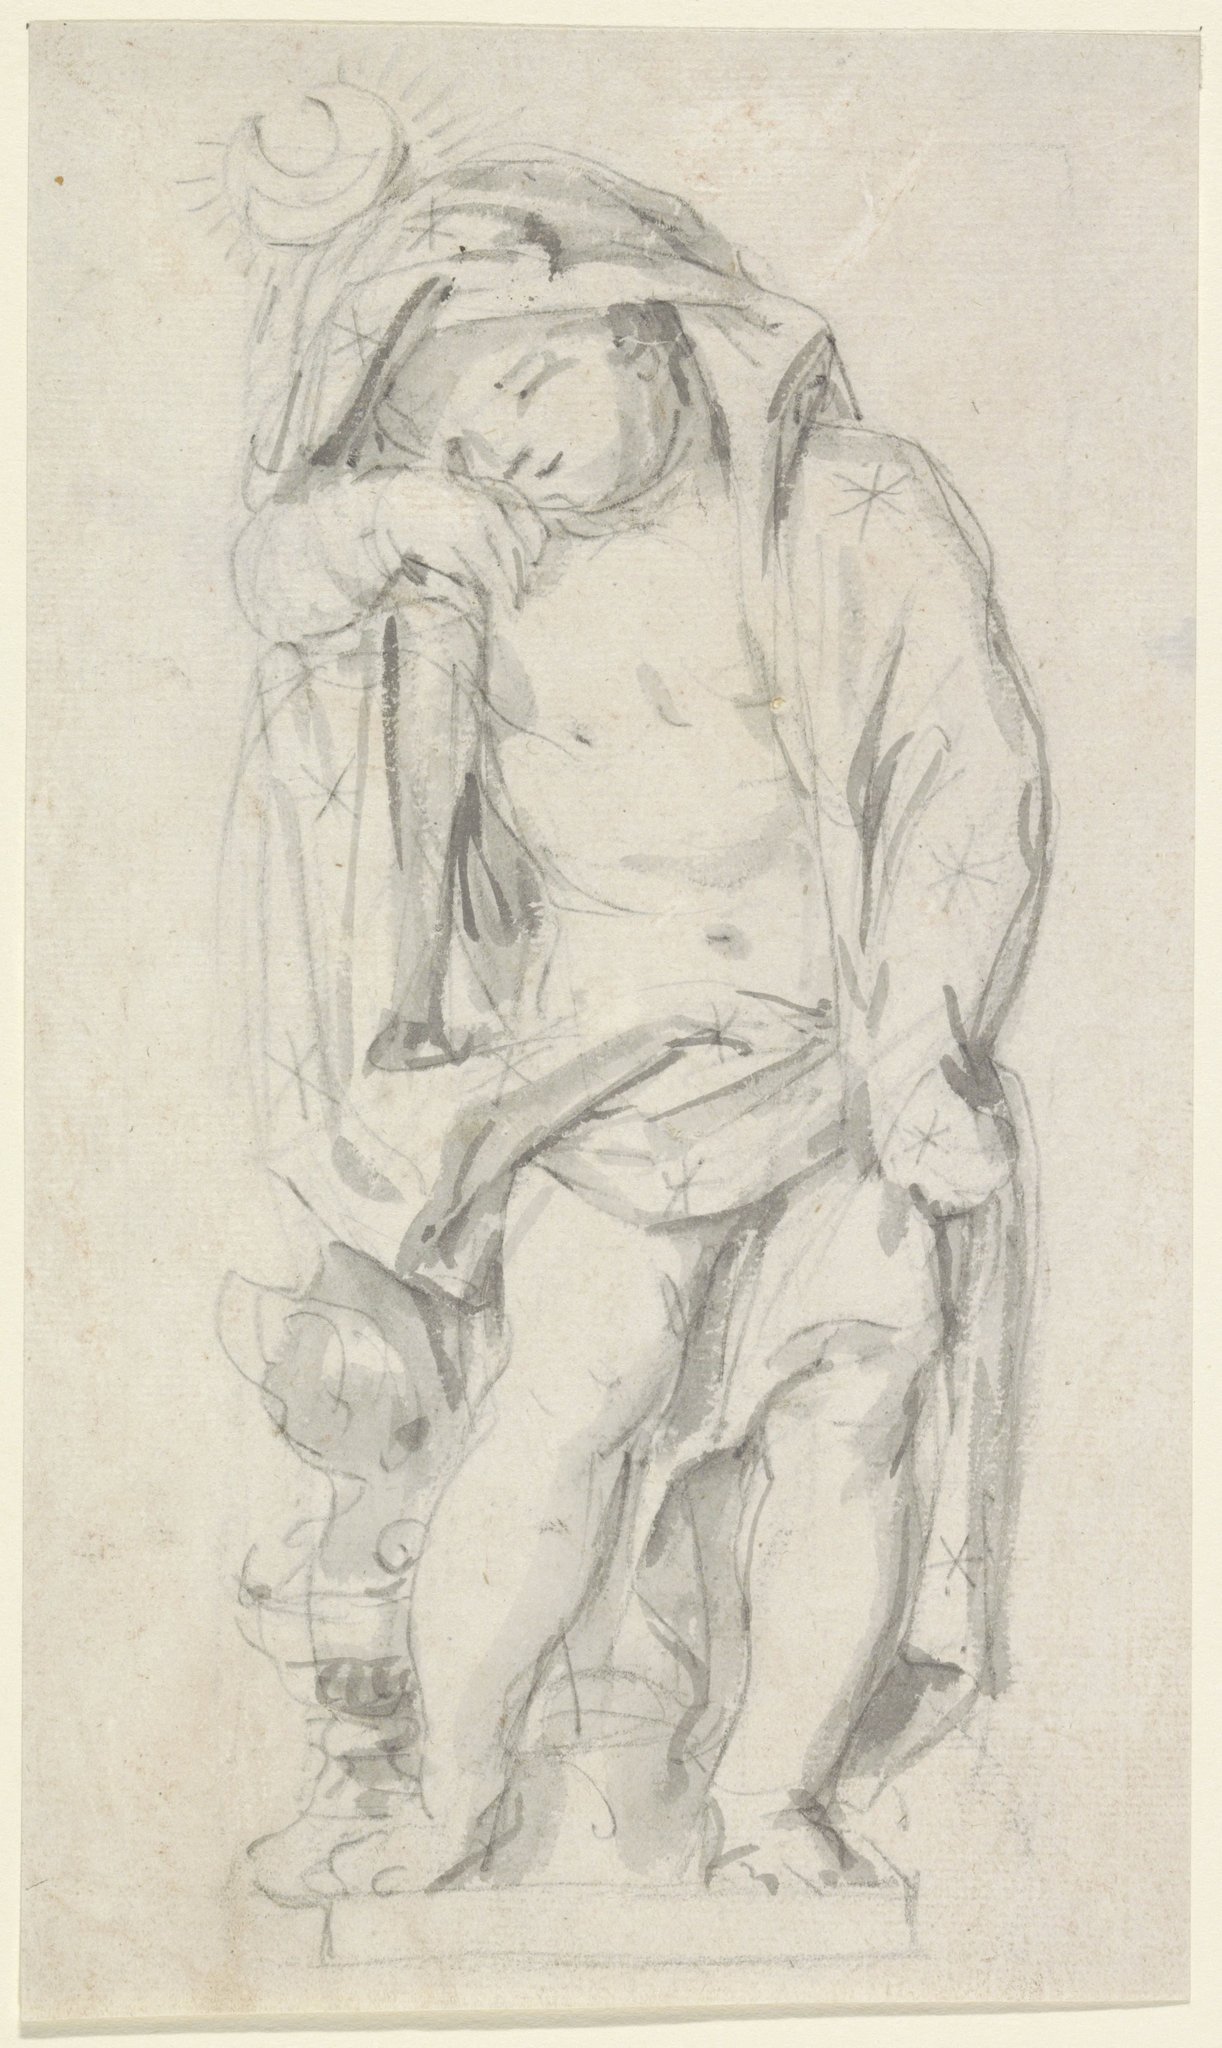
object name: drawing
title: Putto met sterrenmantel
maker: Anonymous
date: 1600-1800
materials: ink, paper, pencil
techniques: brush, pen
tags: stars, cupids: 'amores', 'amoretti', 'putti', coat, cape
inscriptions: collector's mark: Lugt 2228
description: Een treurende putto ten voeten uit met een mantel met sterren en een maan op zijn hoofd.